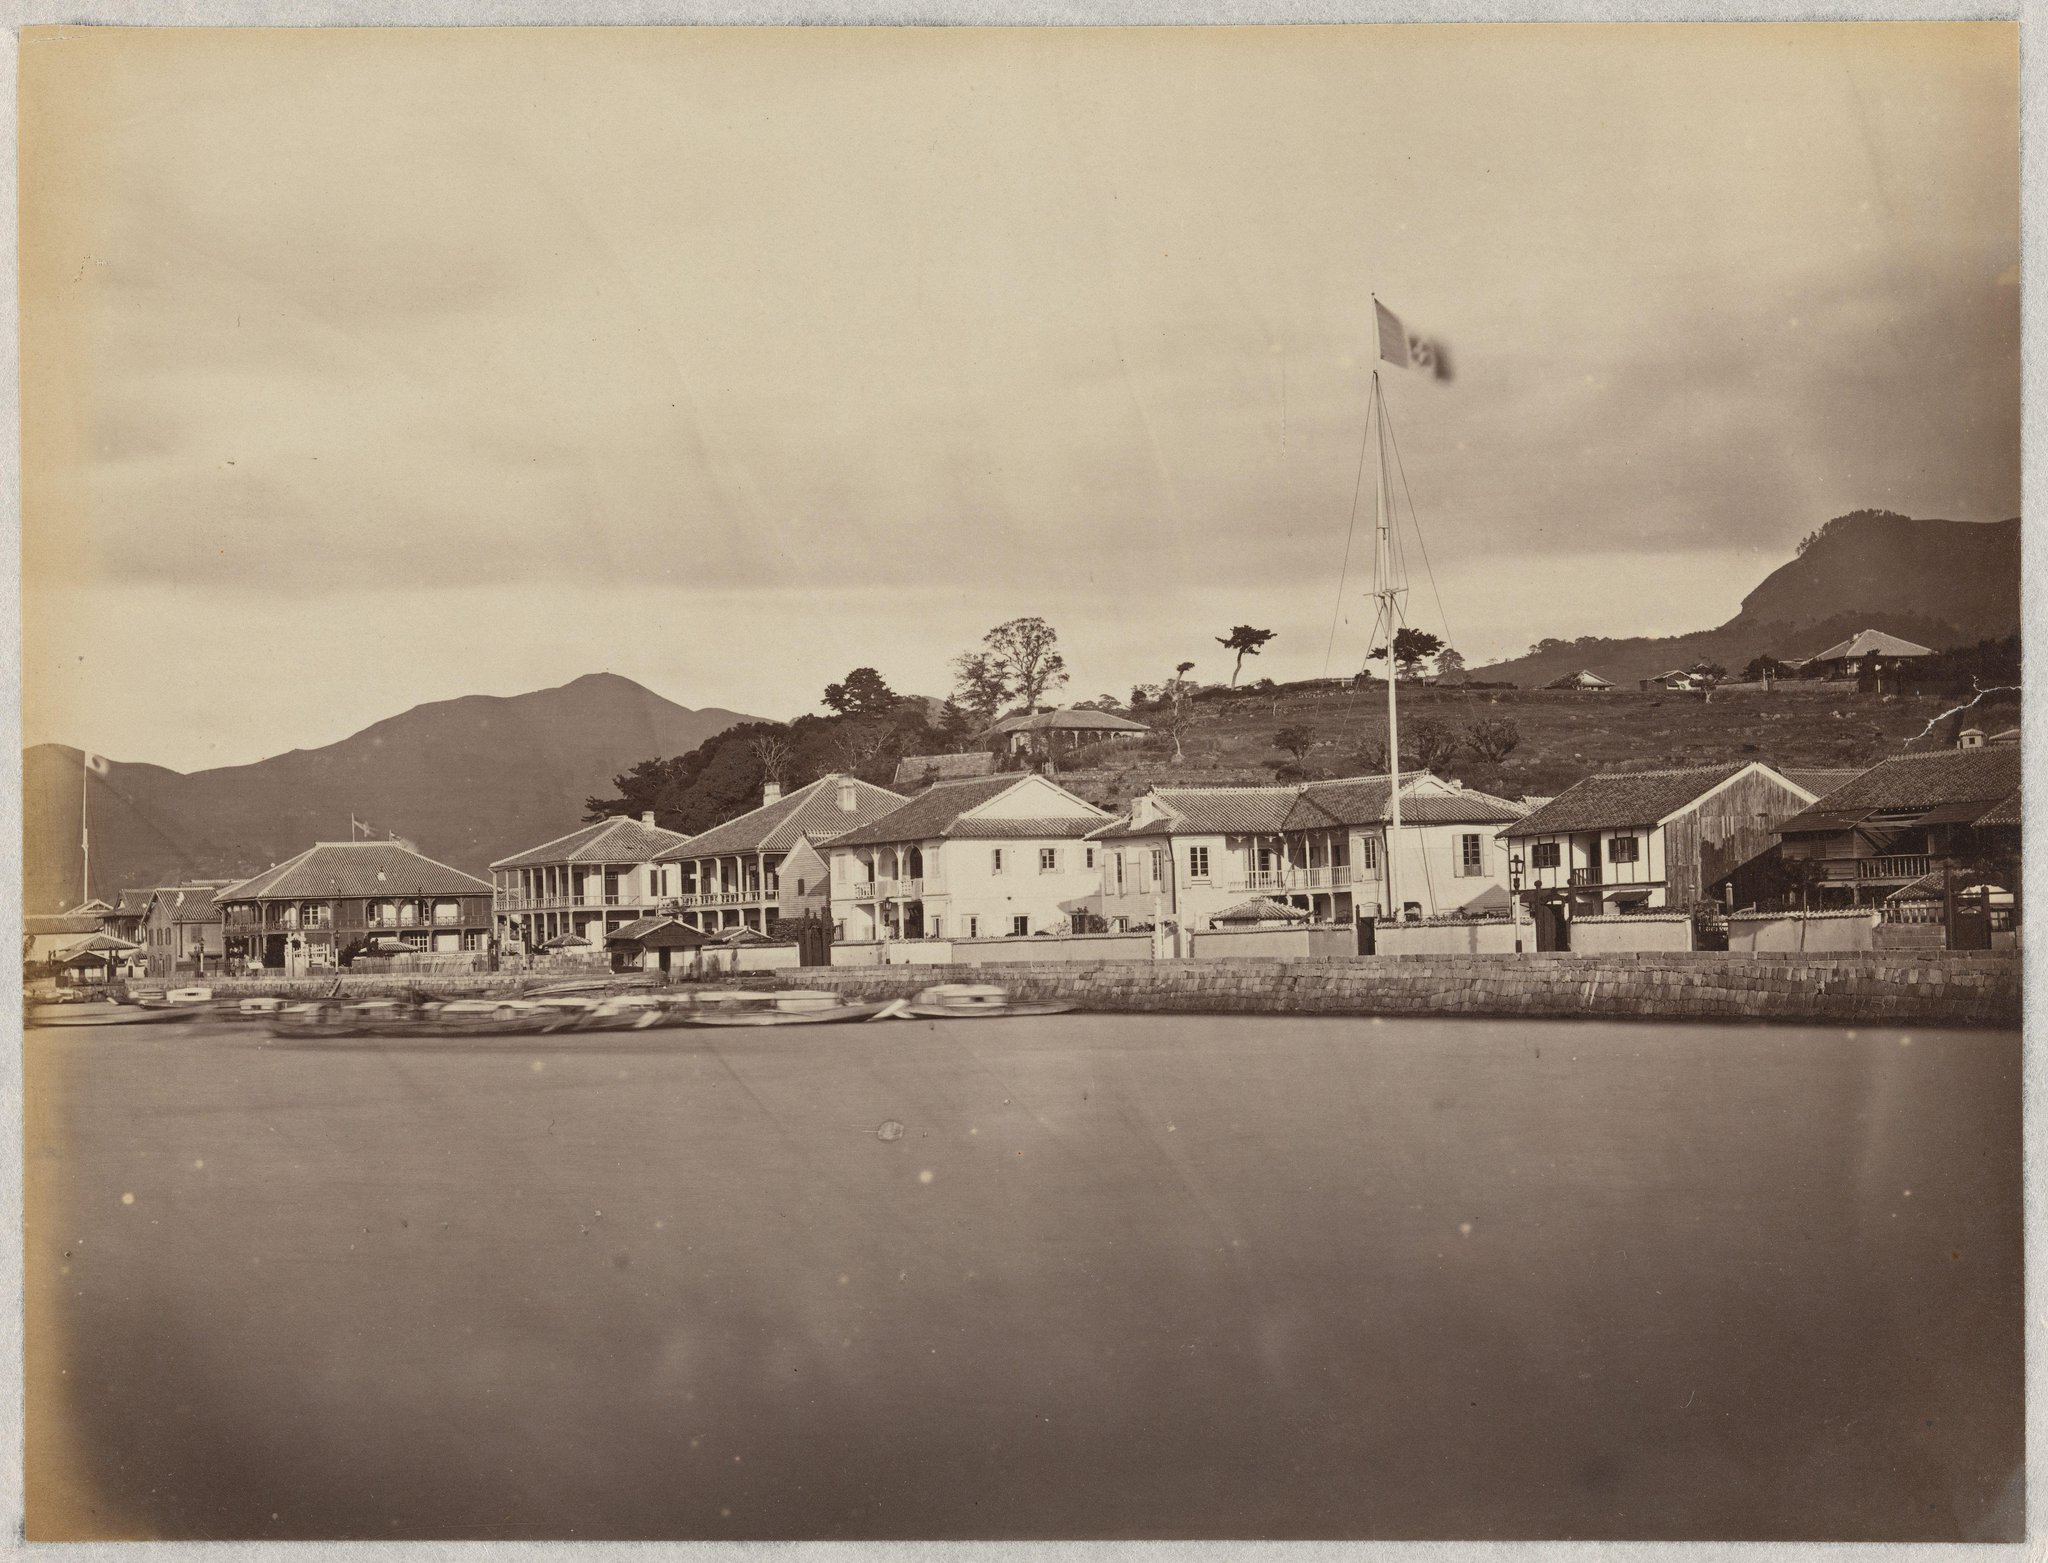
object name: photograph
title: Oura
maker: Anonymous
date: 1865-1870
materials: paper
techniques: albumen print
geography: japan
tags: japan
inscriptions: number: ‘K2’